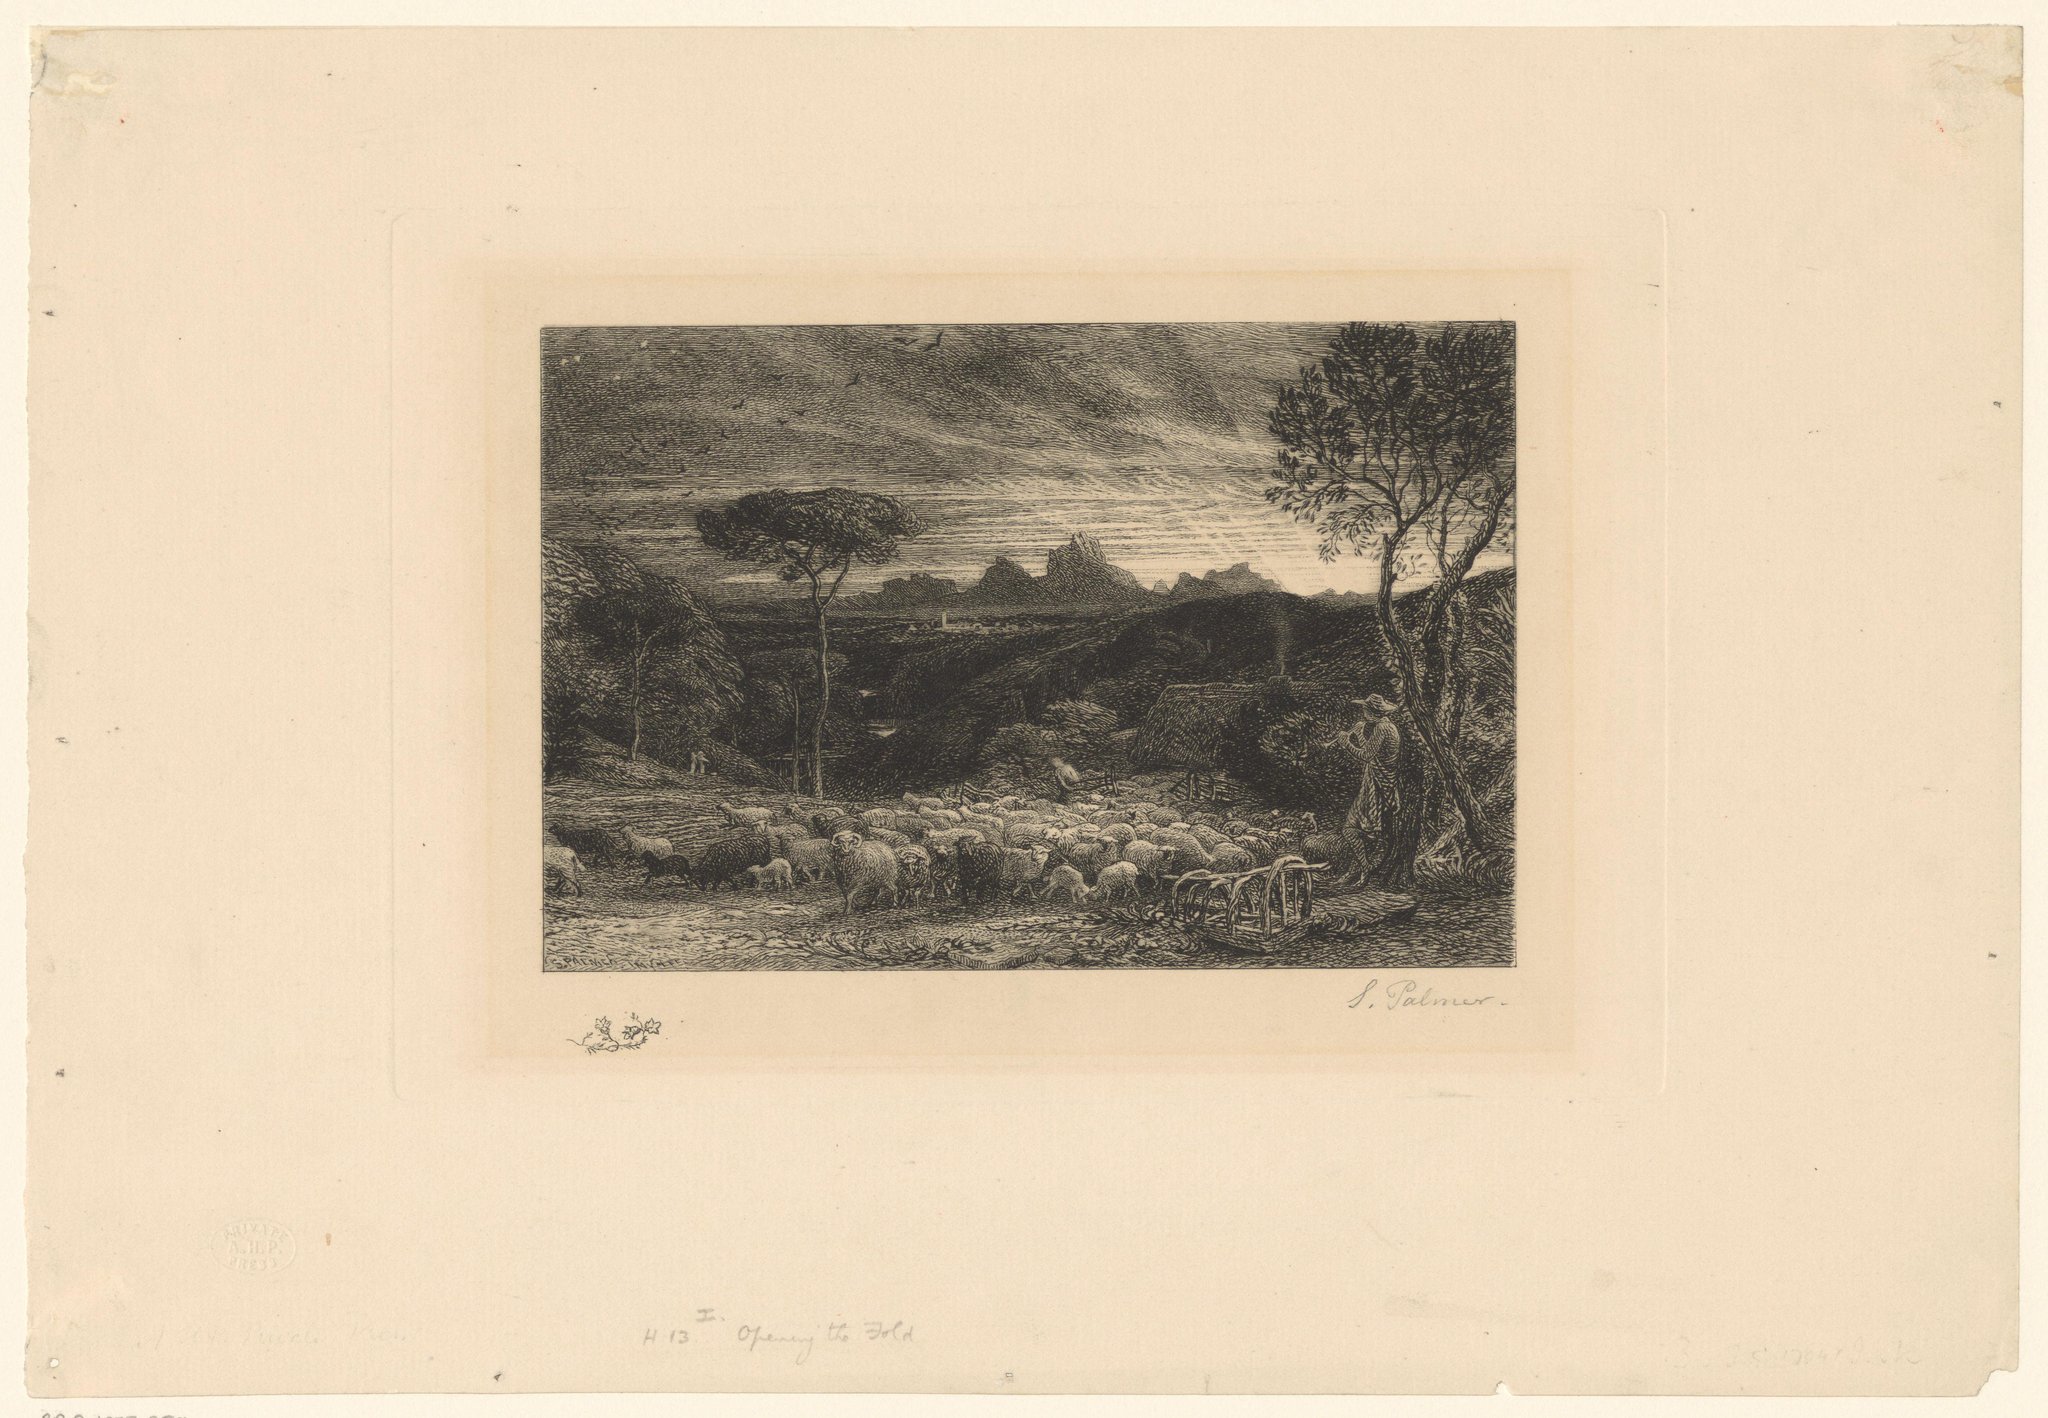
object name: print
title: Opening the Fold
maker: samuel palmer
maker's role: draughtsman, painter, print maker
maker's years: 1805-1881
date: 1880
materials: paper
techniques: etching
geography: england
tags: herding, herdsman, herdswoman, shepherd, shepherdess, cowherd, etc., sheep, sunrise, flute, aulos, tibia - cc - out of doors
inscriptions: collector's mark: Lugt 2228, check stamp: ‘Private A.H.P. Press’, collector's mark: Lugt 2760